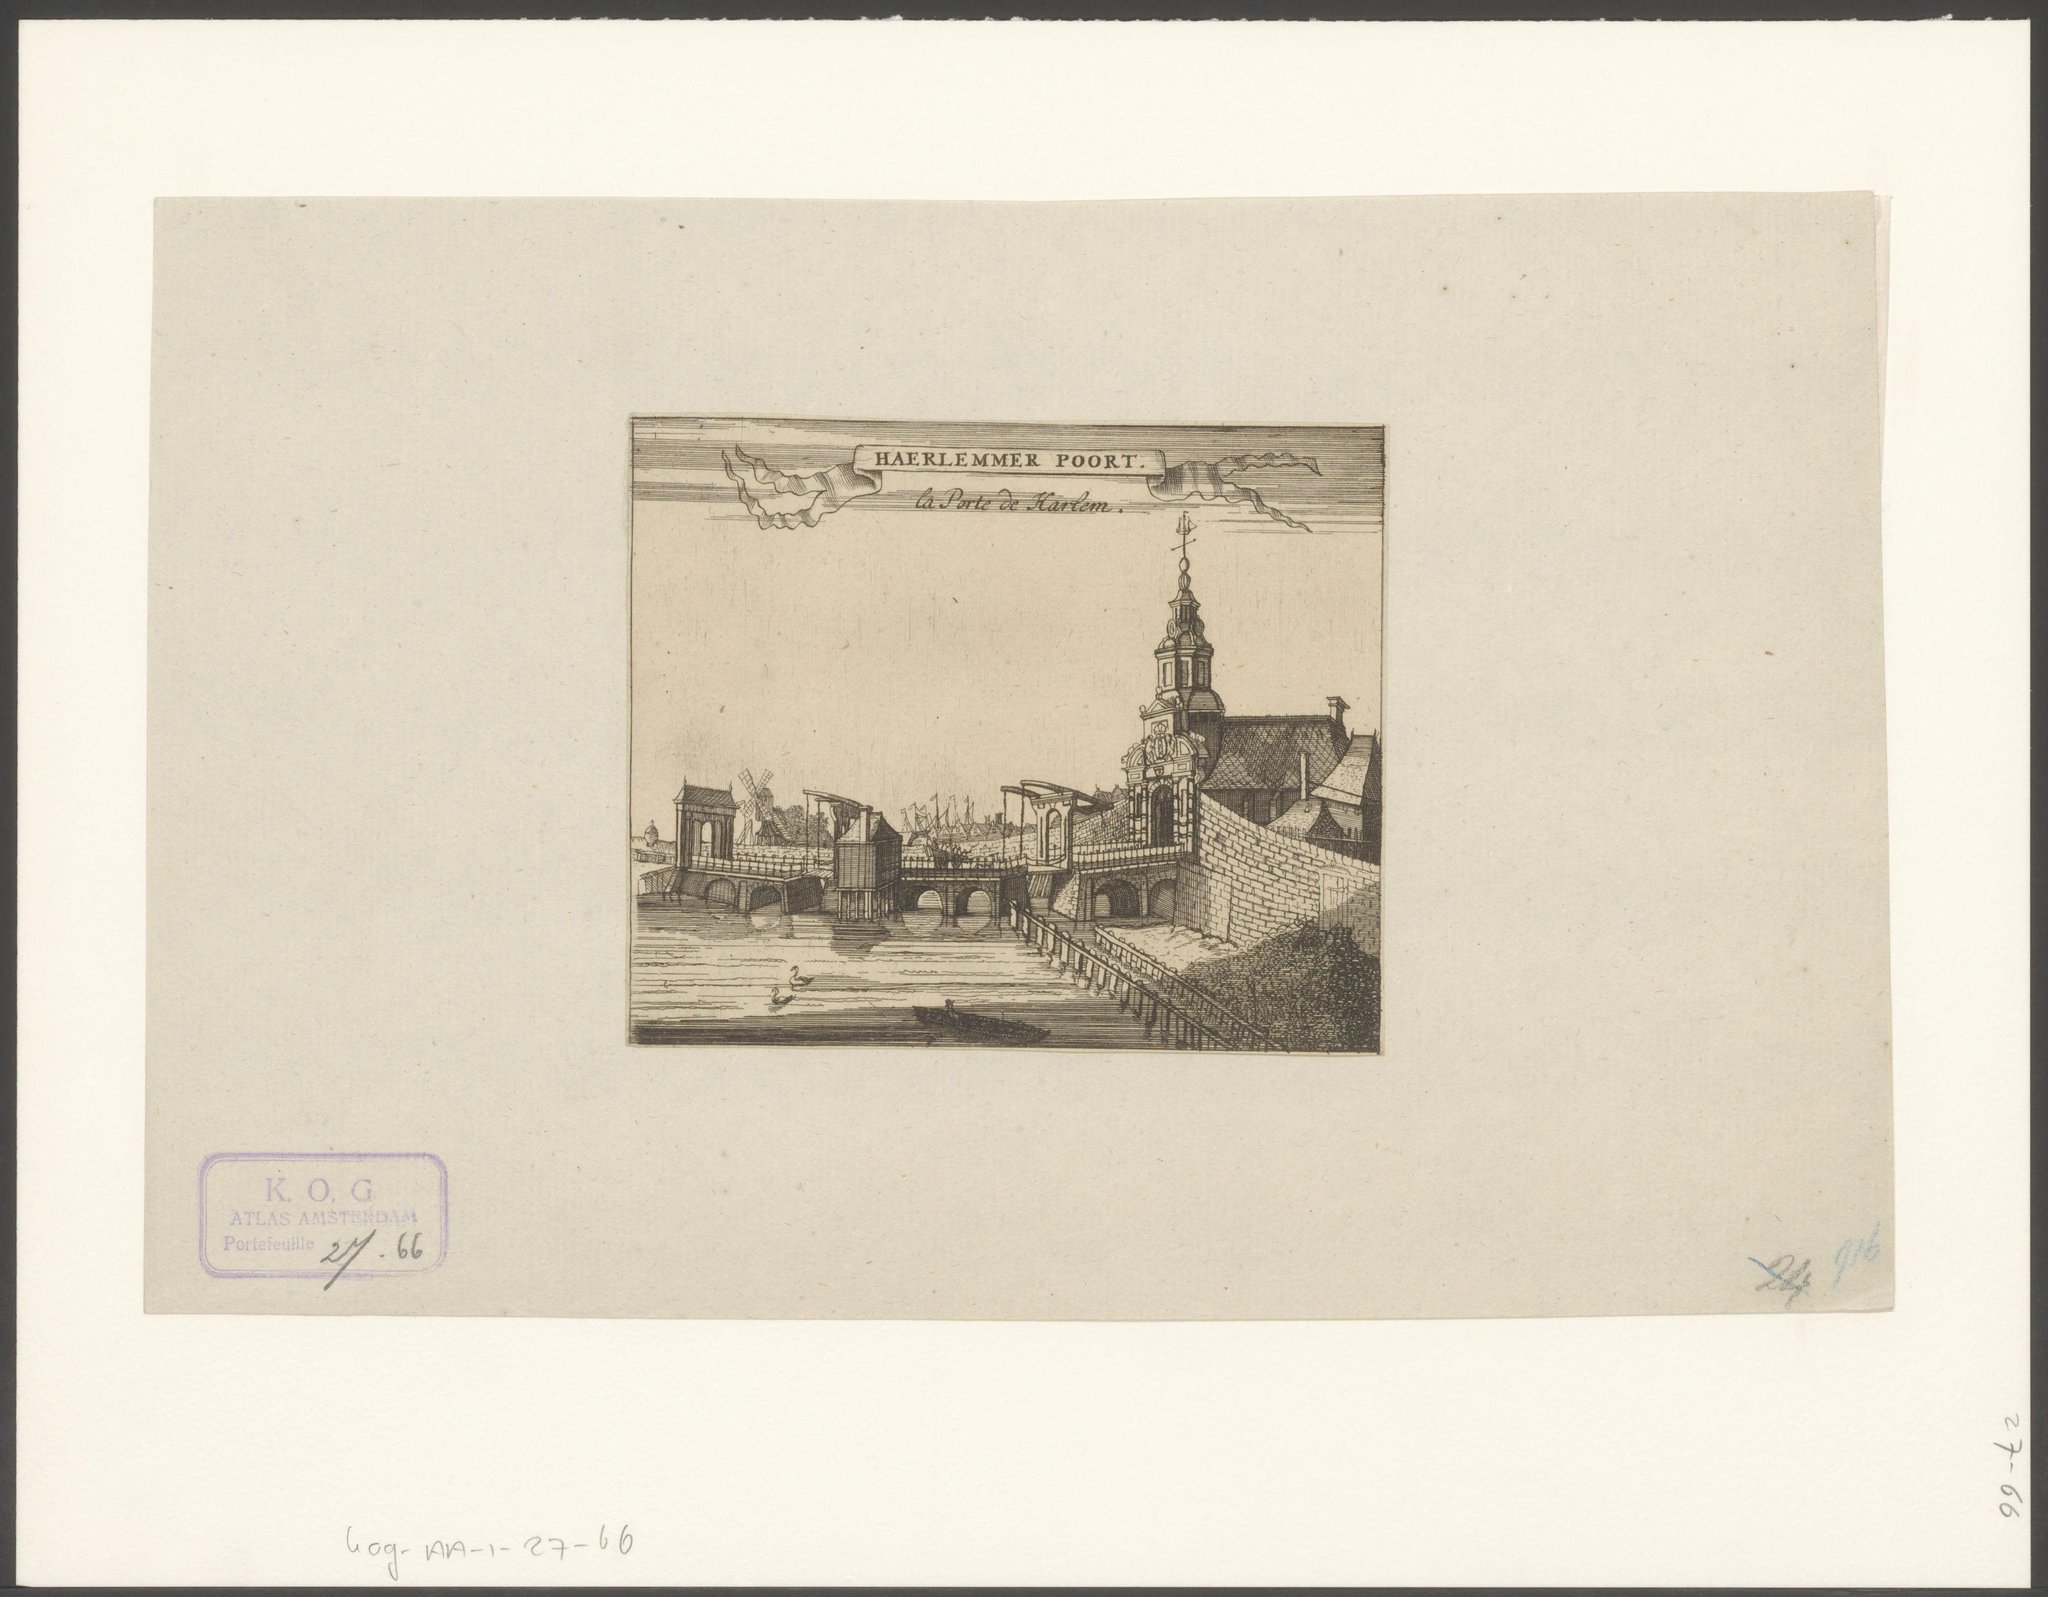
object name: print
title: Haerlemmer Poort / La Porte de Harlem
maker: pieter schenk (i)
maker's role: print maker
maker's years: 1660-1711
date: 1650-1699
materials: paper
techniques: engraving, etching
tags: rowing-boat, canoe, etc., bridge in city across river, canal, etc., city-gate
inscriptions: collector's mark: Lugt 1641b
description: Onderwerpsrubriek binnen de Atlas Amsterdam: B. Poorten, verzamelbladen, D. Haarlemmerpoort(en).